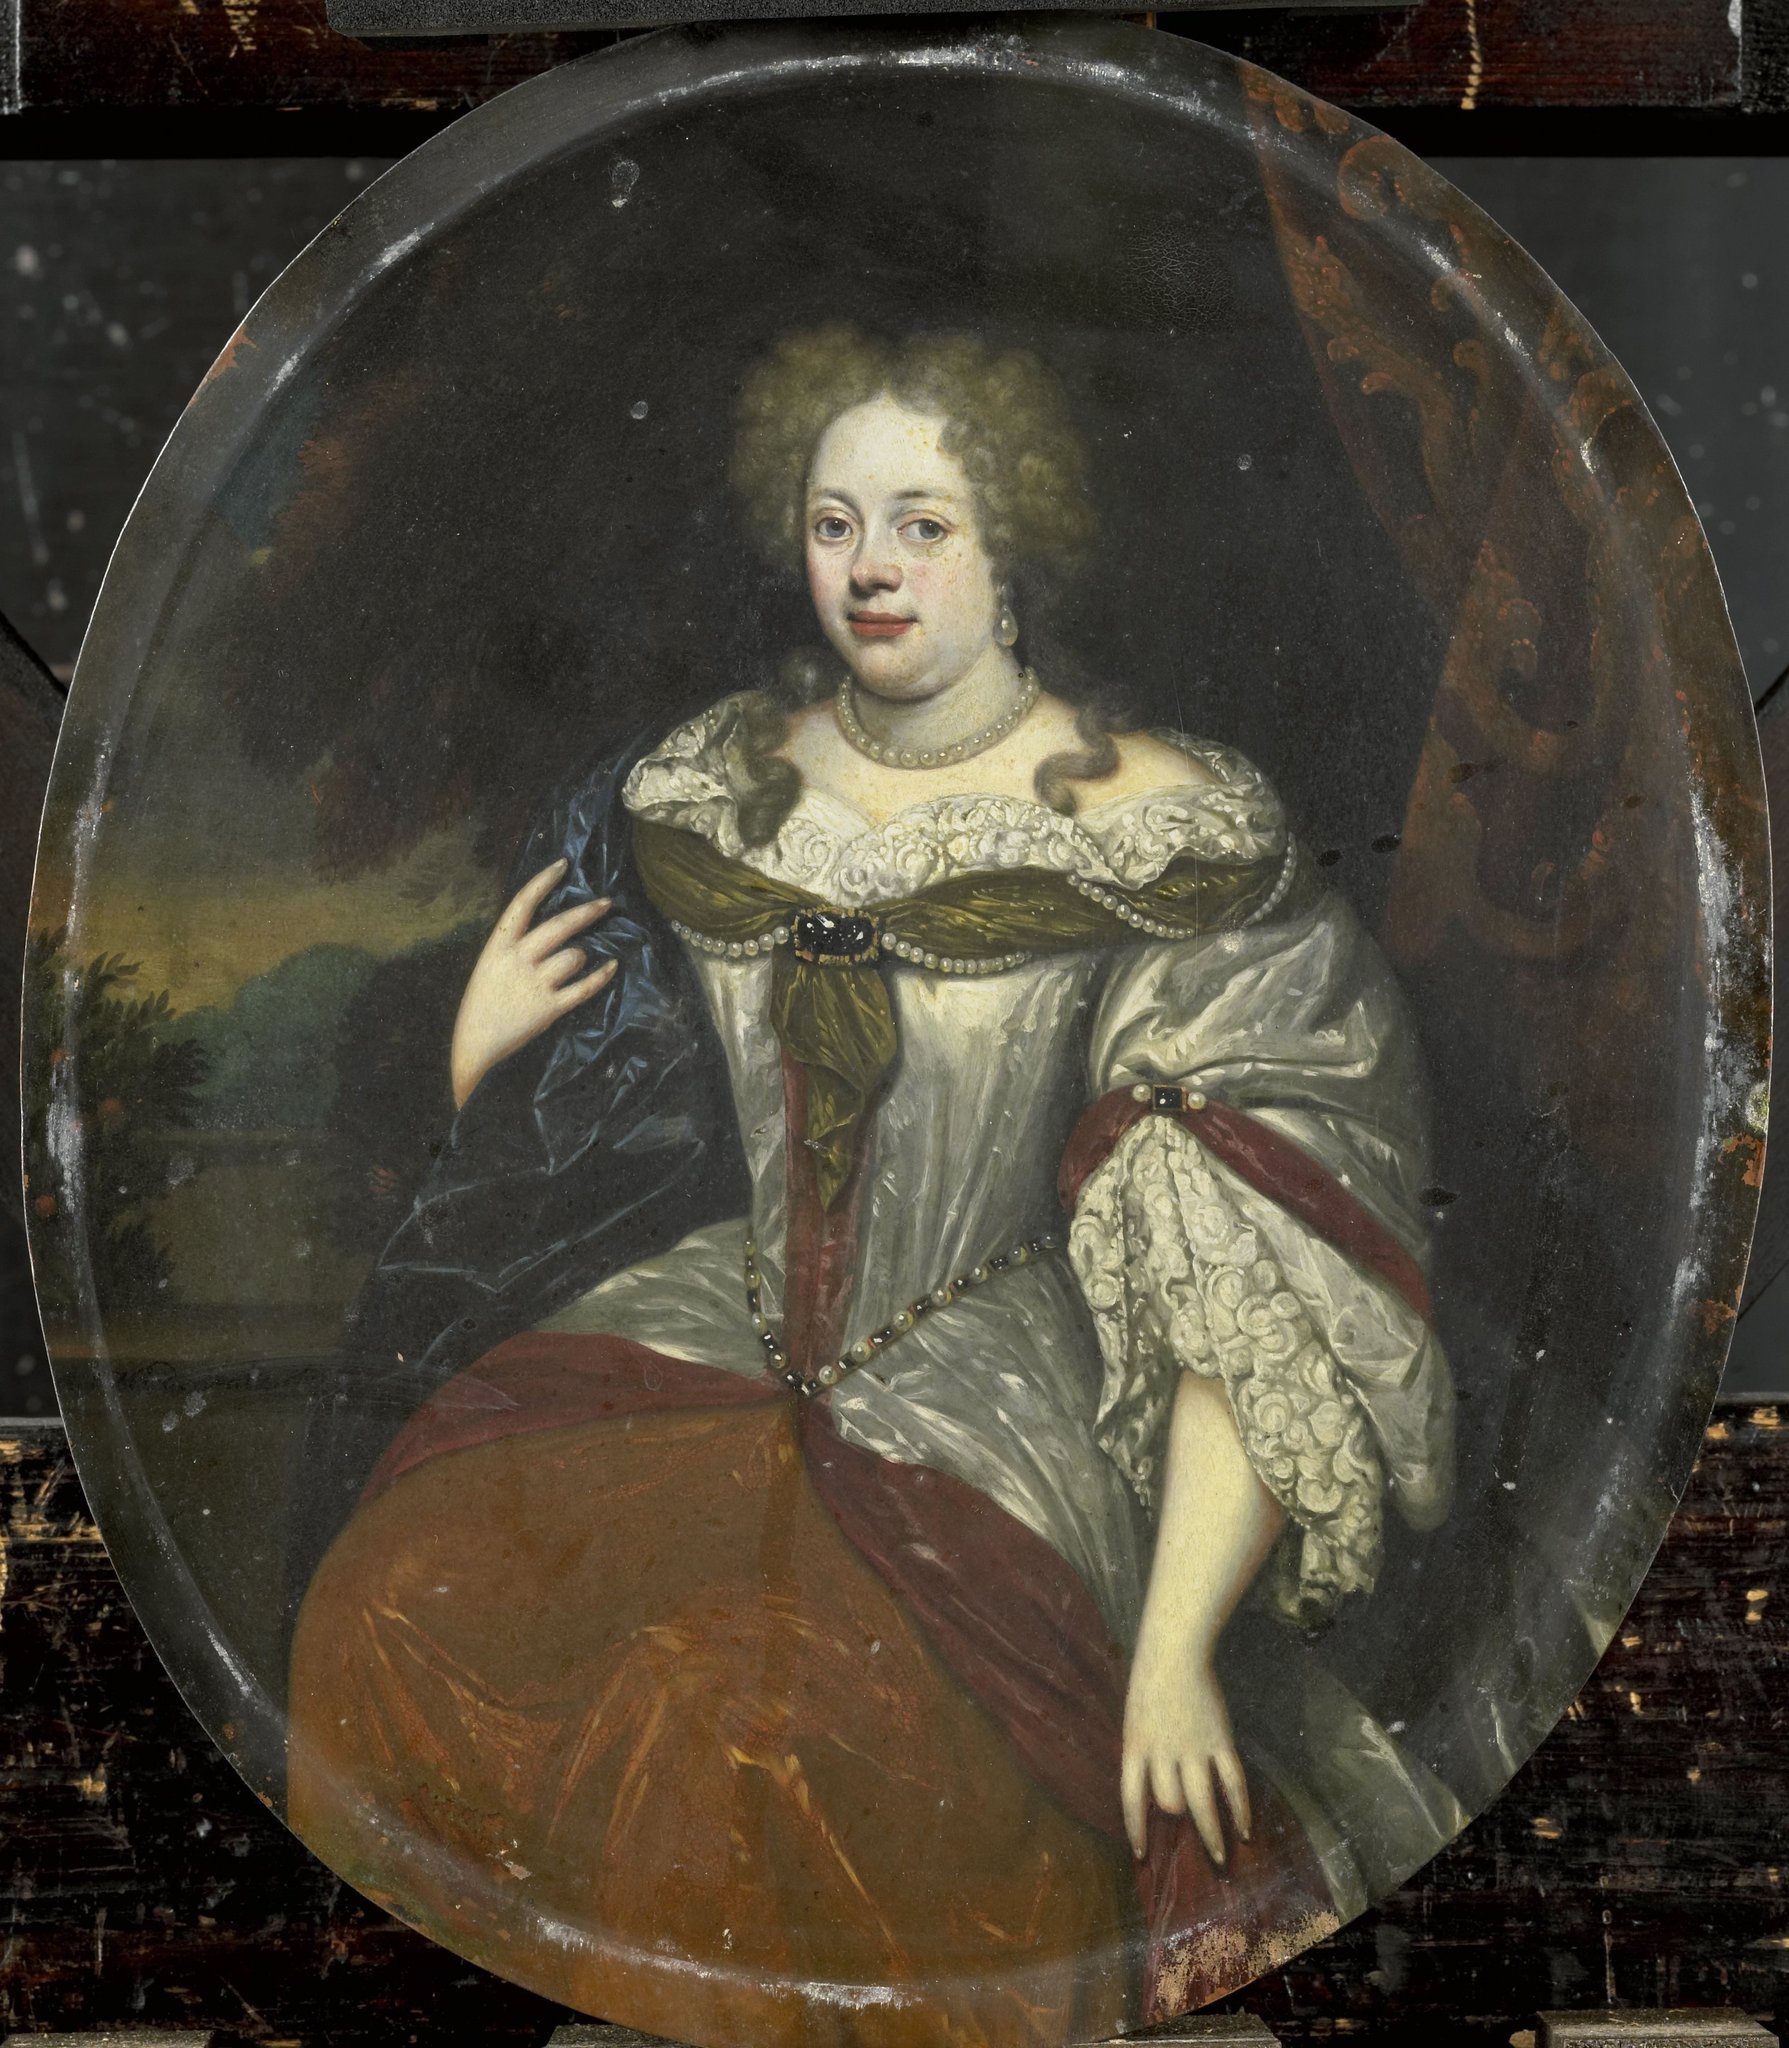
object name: painting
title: Portrait of Frouck, Barones van Aylva, Wife of Hans Willem van Aylva after 1658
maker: hendrick de valk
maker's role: painter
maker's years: 1674-1719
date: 1693-1717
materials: copper, oil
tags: historical persons - bb - woman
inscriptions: signature: ‘H. de Falk Fc.’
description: Portret van Frouck, barones van Aylva, sedert 1658 echtgenote van Hans Willem van Aylva. Kniestuk in ovaal, zittend voor een balustrade, op de achtergrond een landschap. Pendant van SK-A-1401.